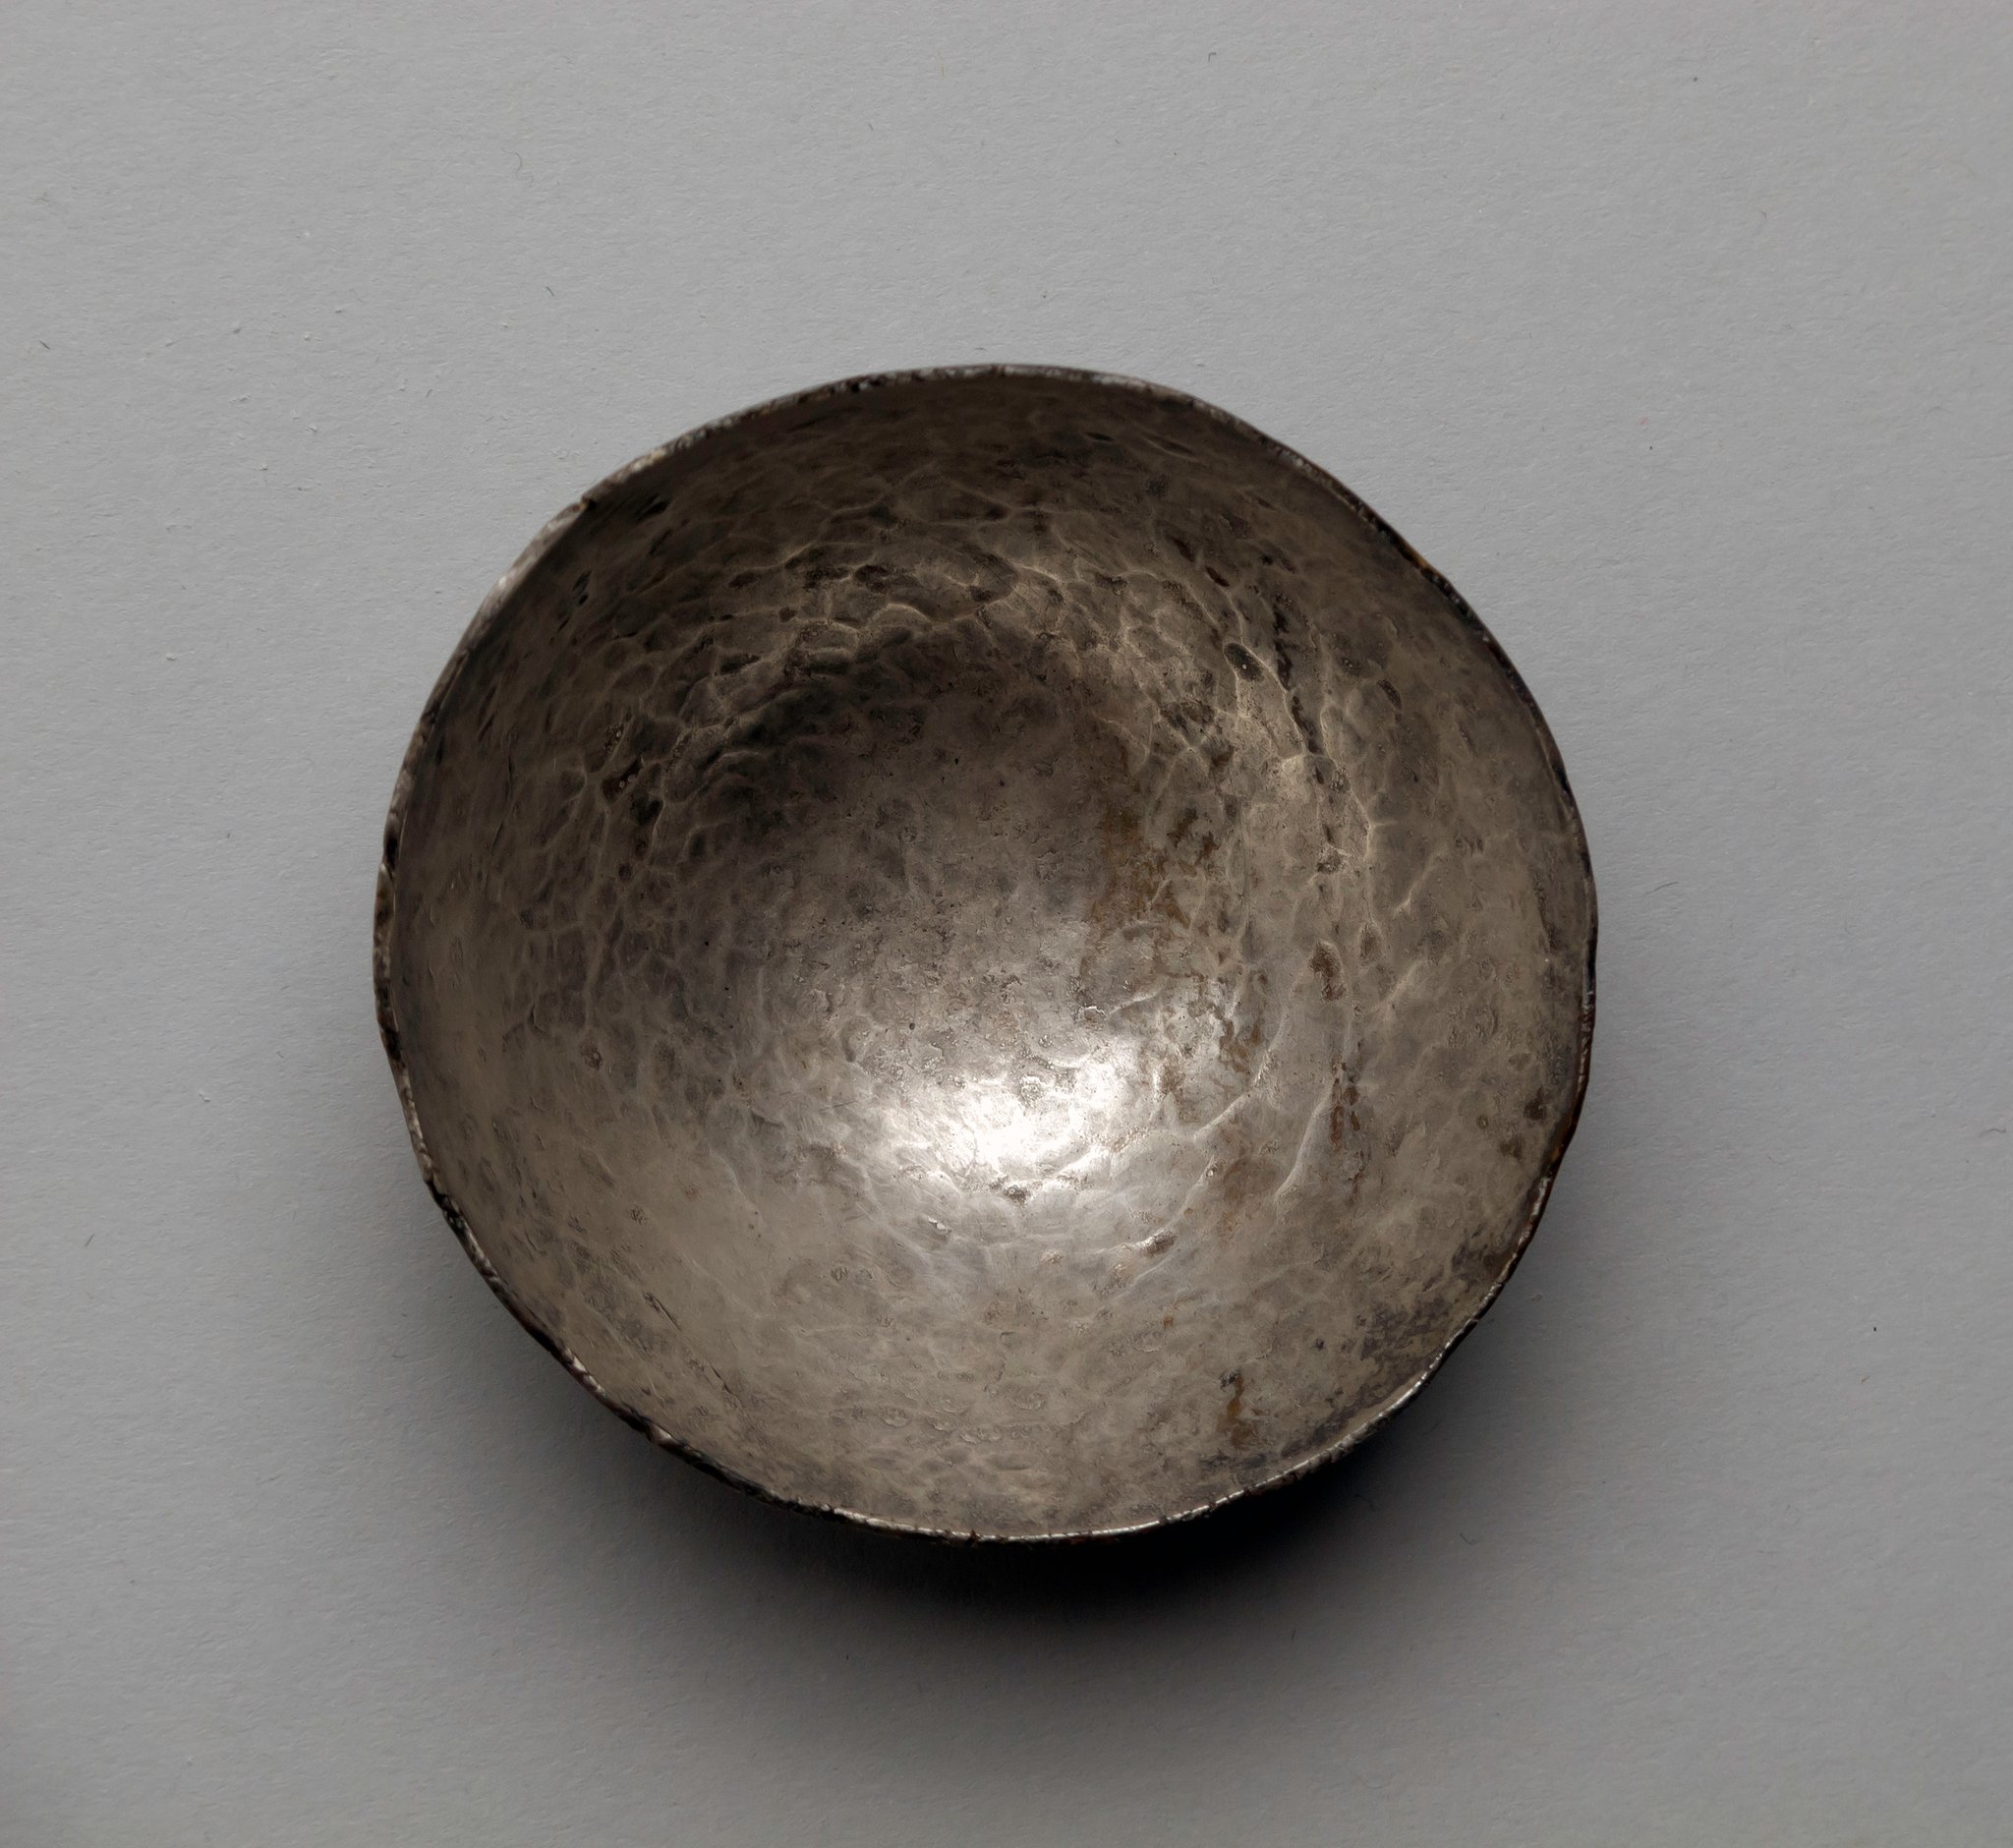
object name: bowl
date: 7000 BCE-330 CE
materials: silver